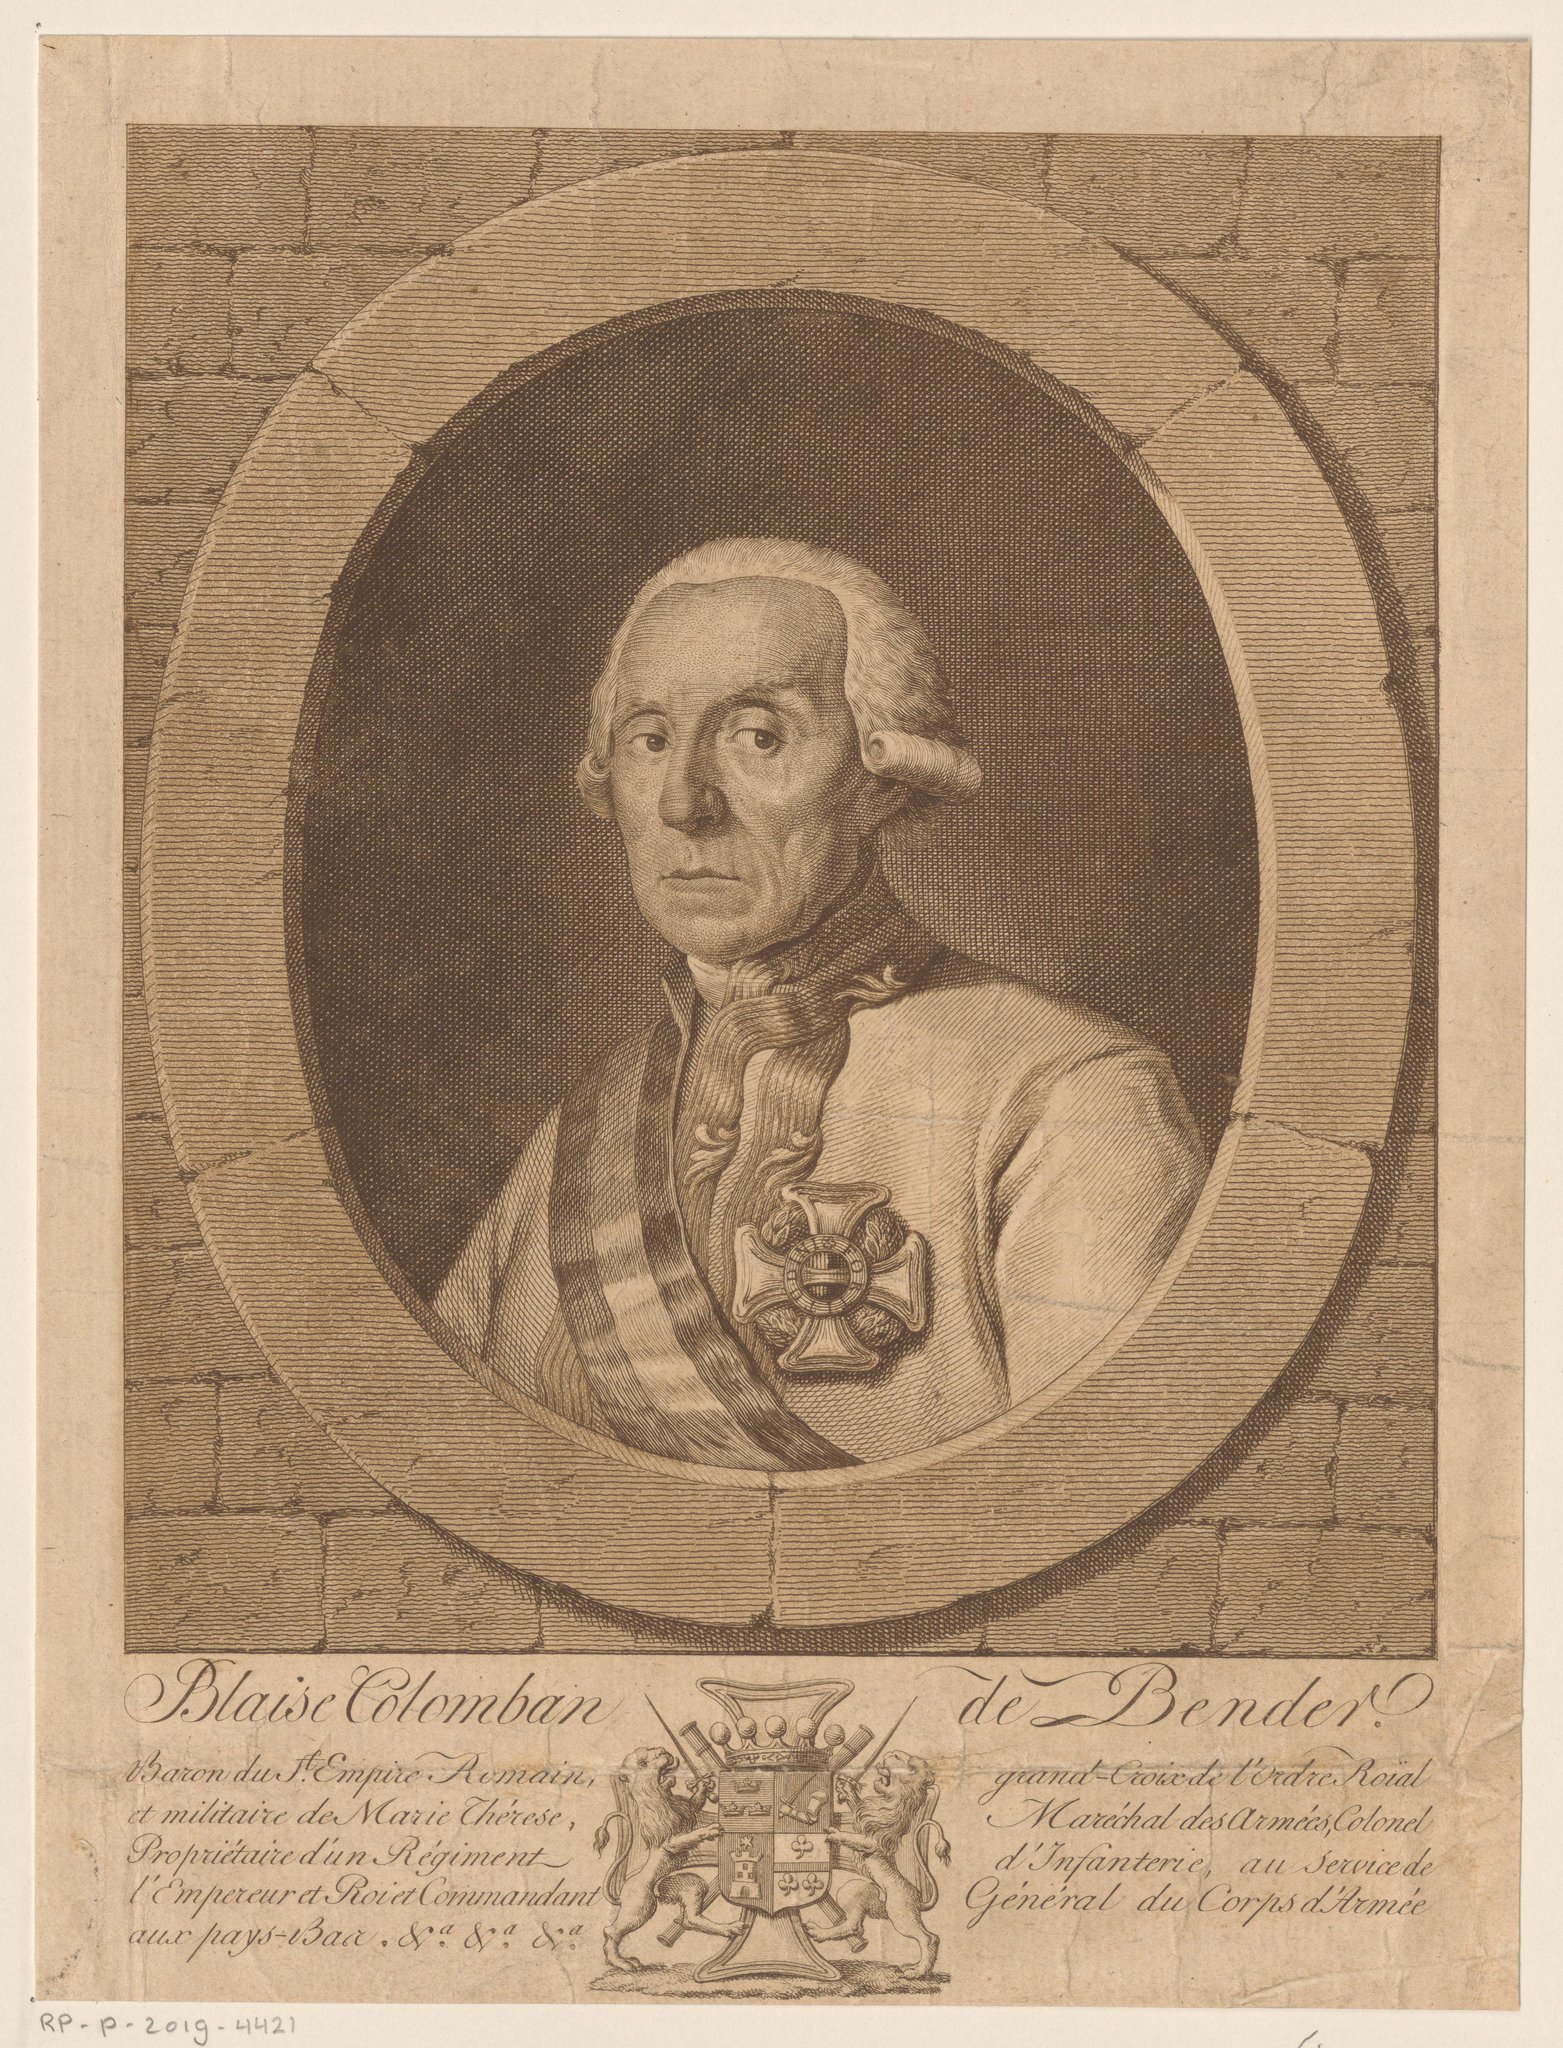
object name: print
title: Portret van Blasius Columban von Bender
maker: Anonymous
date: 1782-1799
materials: paper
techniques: engraving, etching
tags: prague, historical persons, armorial bearing, heraldry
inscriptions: collector's mark: Lugt 2228